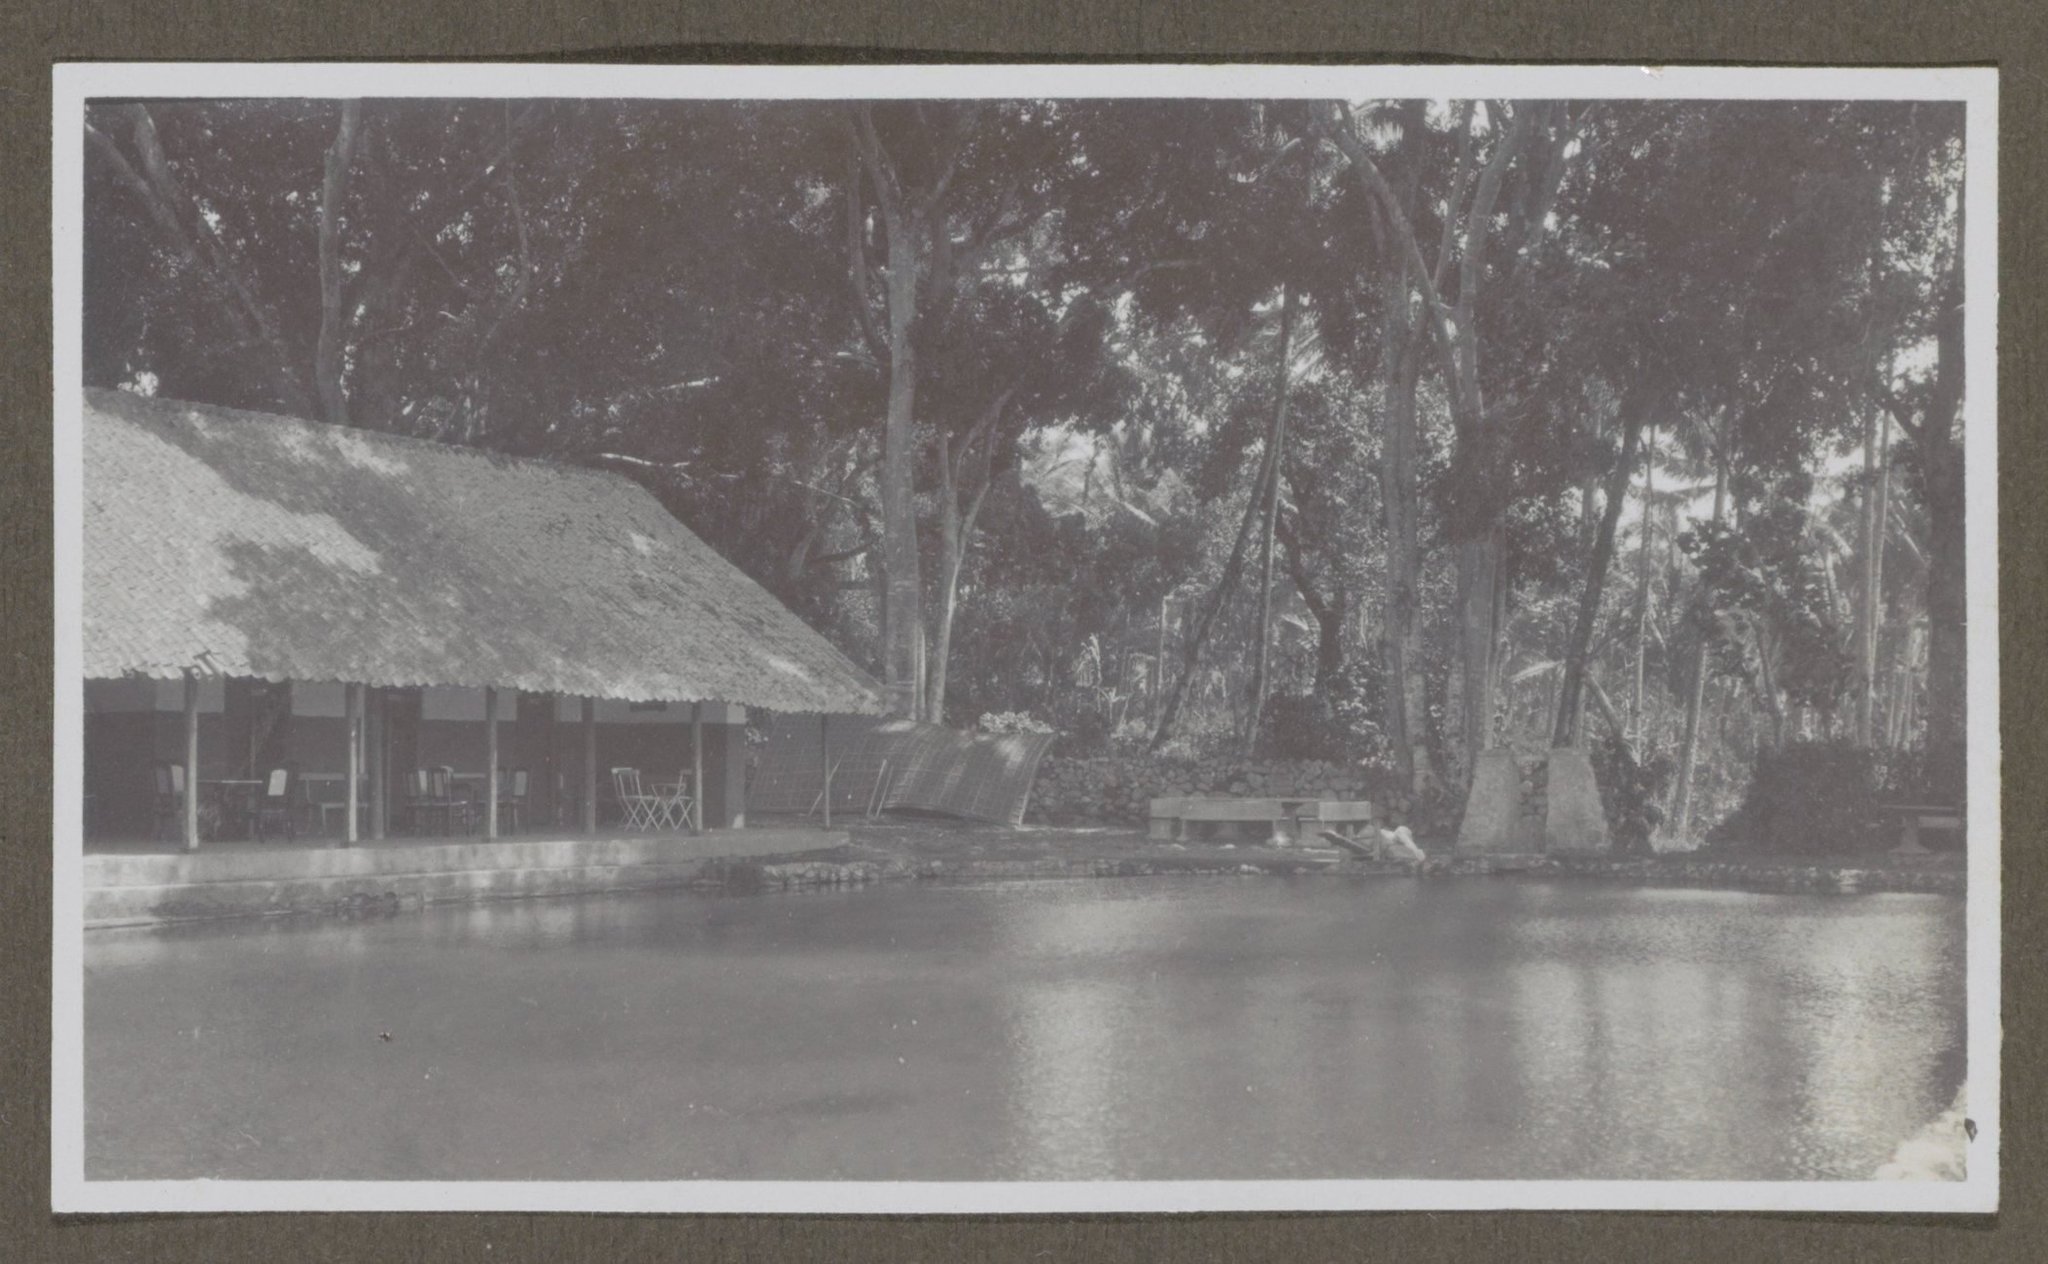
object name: photograph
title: Gebouw met overdekte zitjes aan een water, mogelijk een horecagelegenheid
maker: Anonymous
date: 1920-1930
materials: photographic support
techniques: gelatin silver print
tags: garden pond, hotel, hostelry, inn, dutch east indies, the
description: Onderdeel van familiealbum Nederlands-Indië.